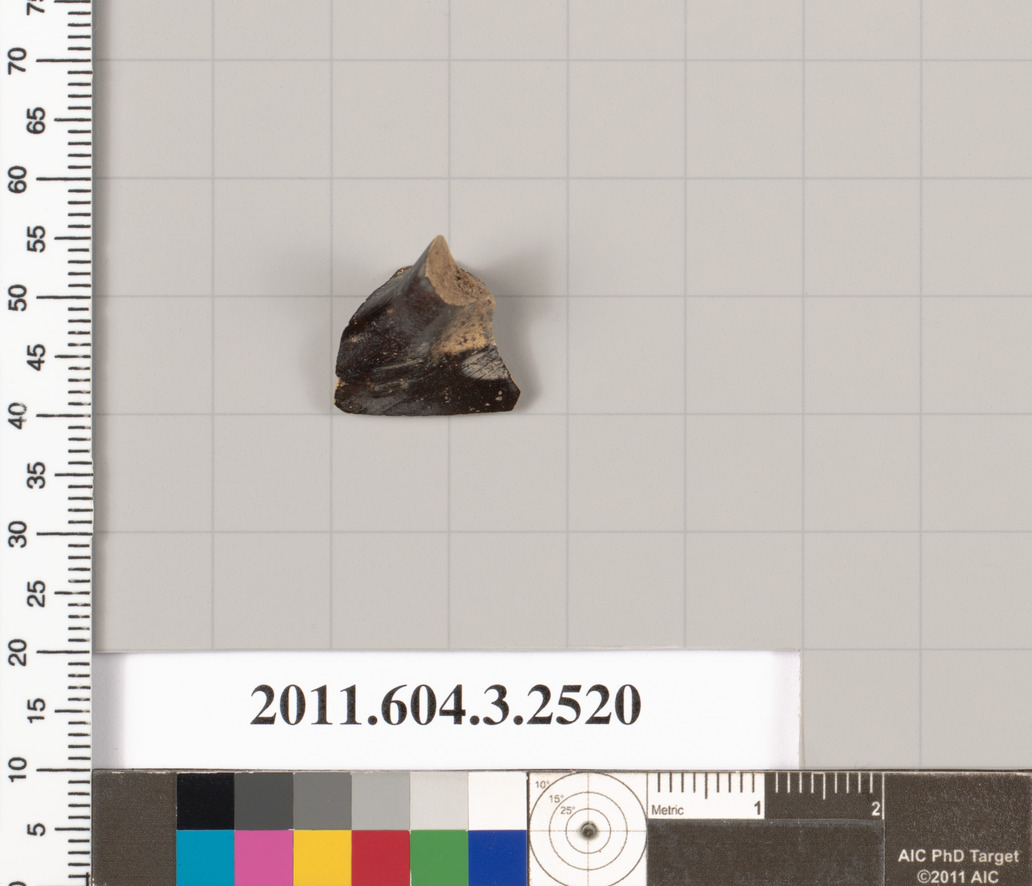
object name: kylix fragment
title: Terracotta fragment of a kylix (drinking cup)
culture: greek, attic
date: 600-401 BCE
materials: terracotta